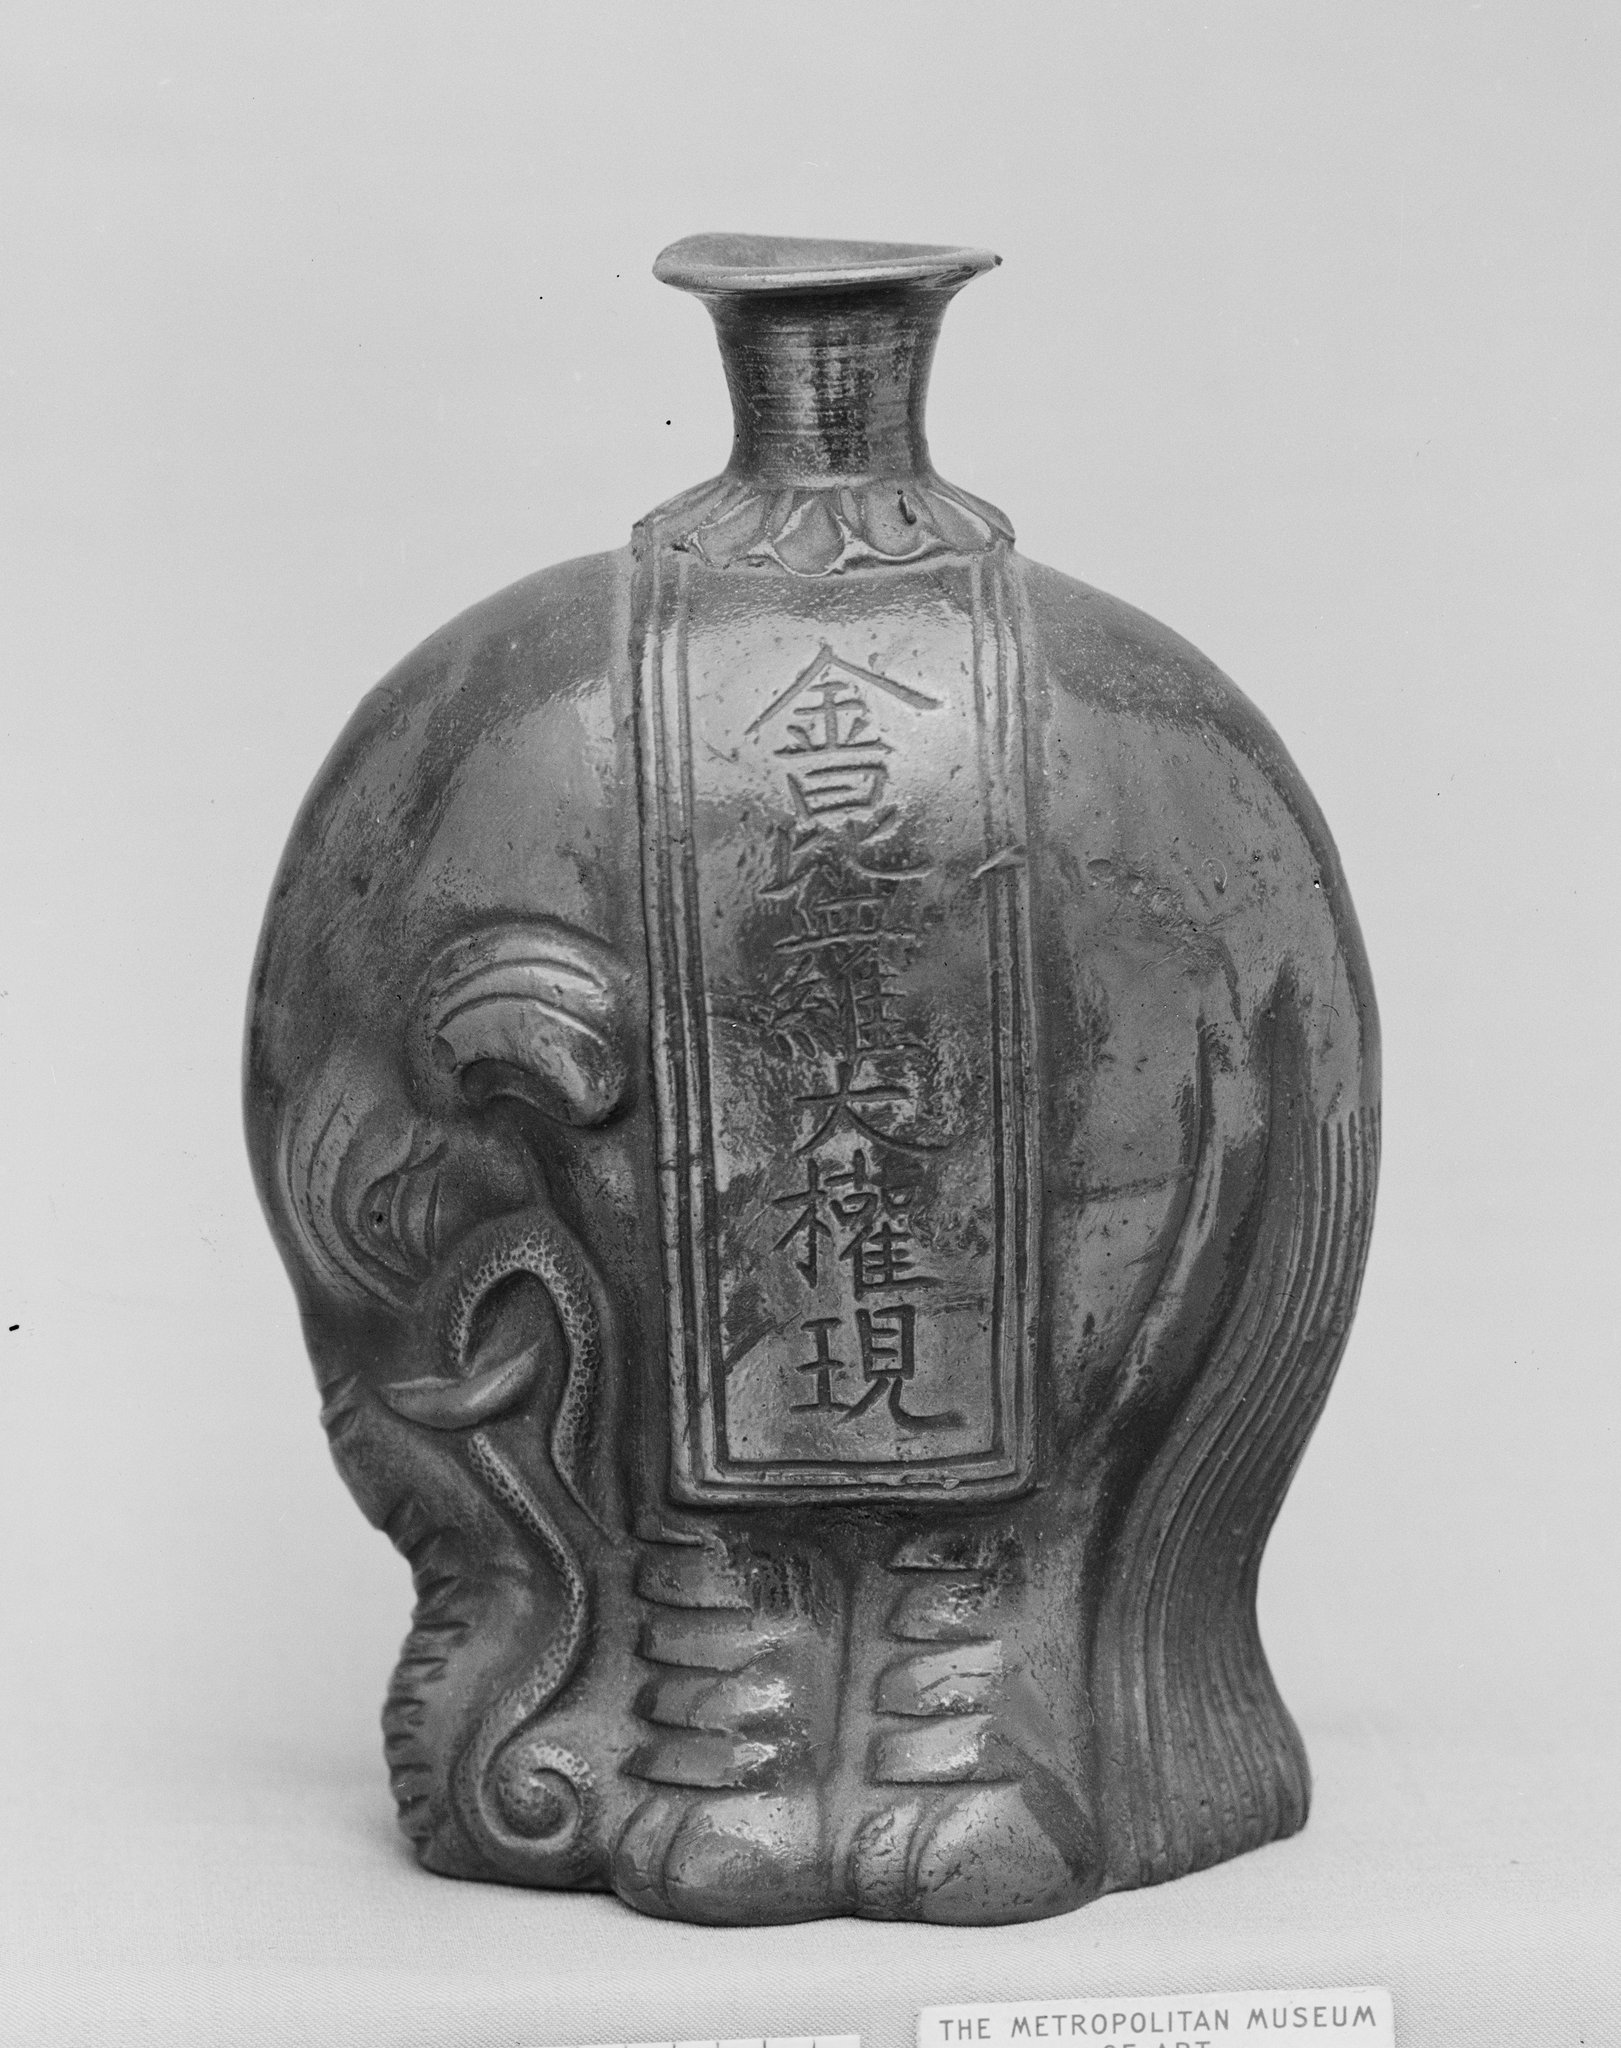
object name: bottle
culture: japanese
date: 1801-1900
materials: clay, glaze